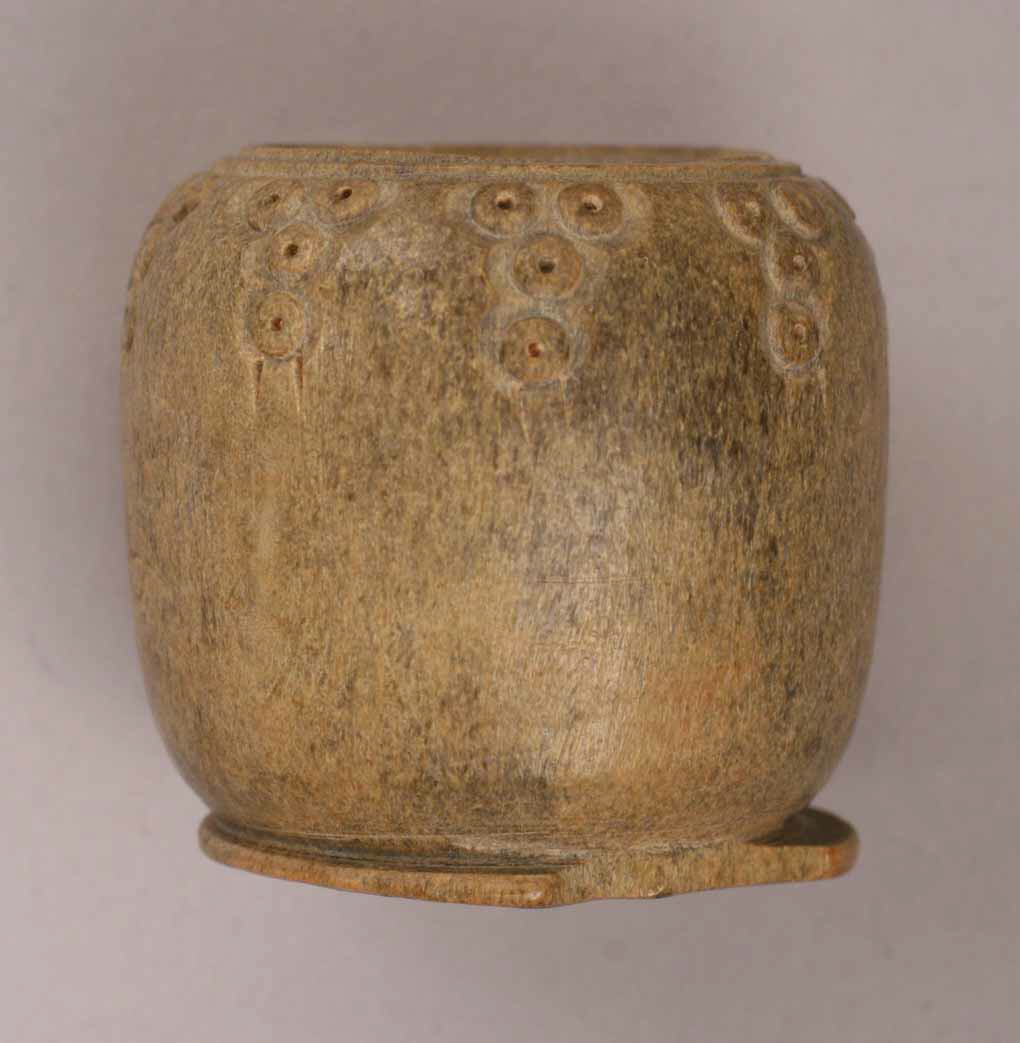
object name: jar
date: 201-1200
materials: bone, paint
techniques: incising, inlay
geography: egypt